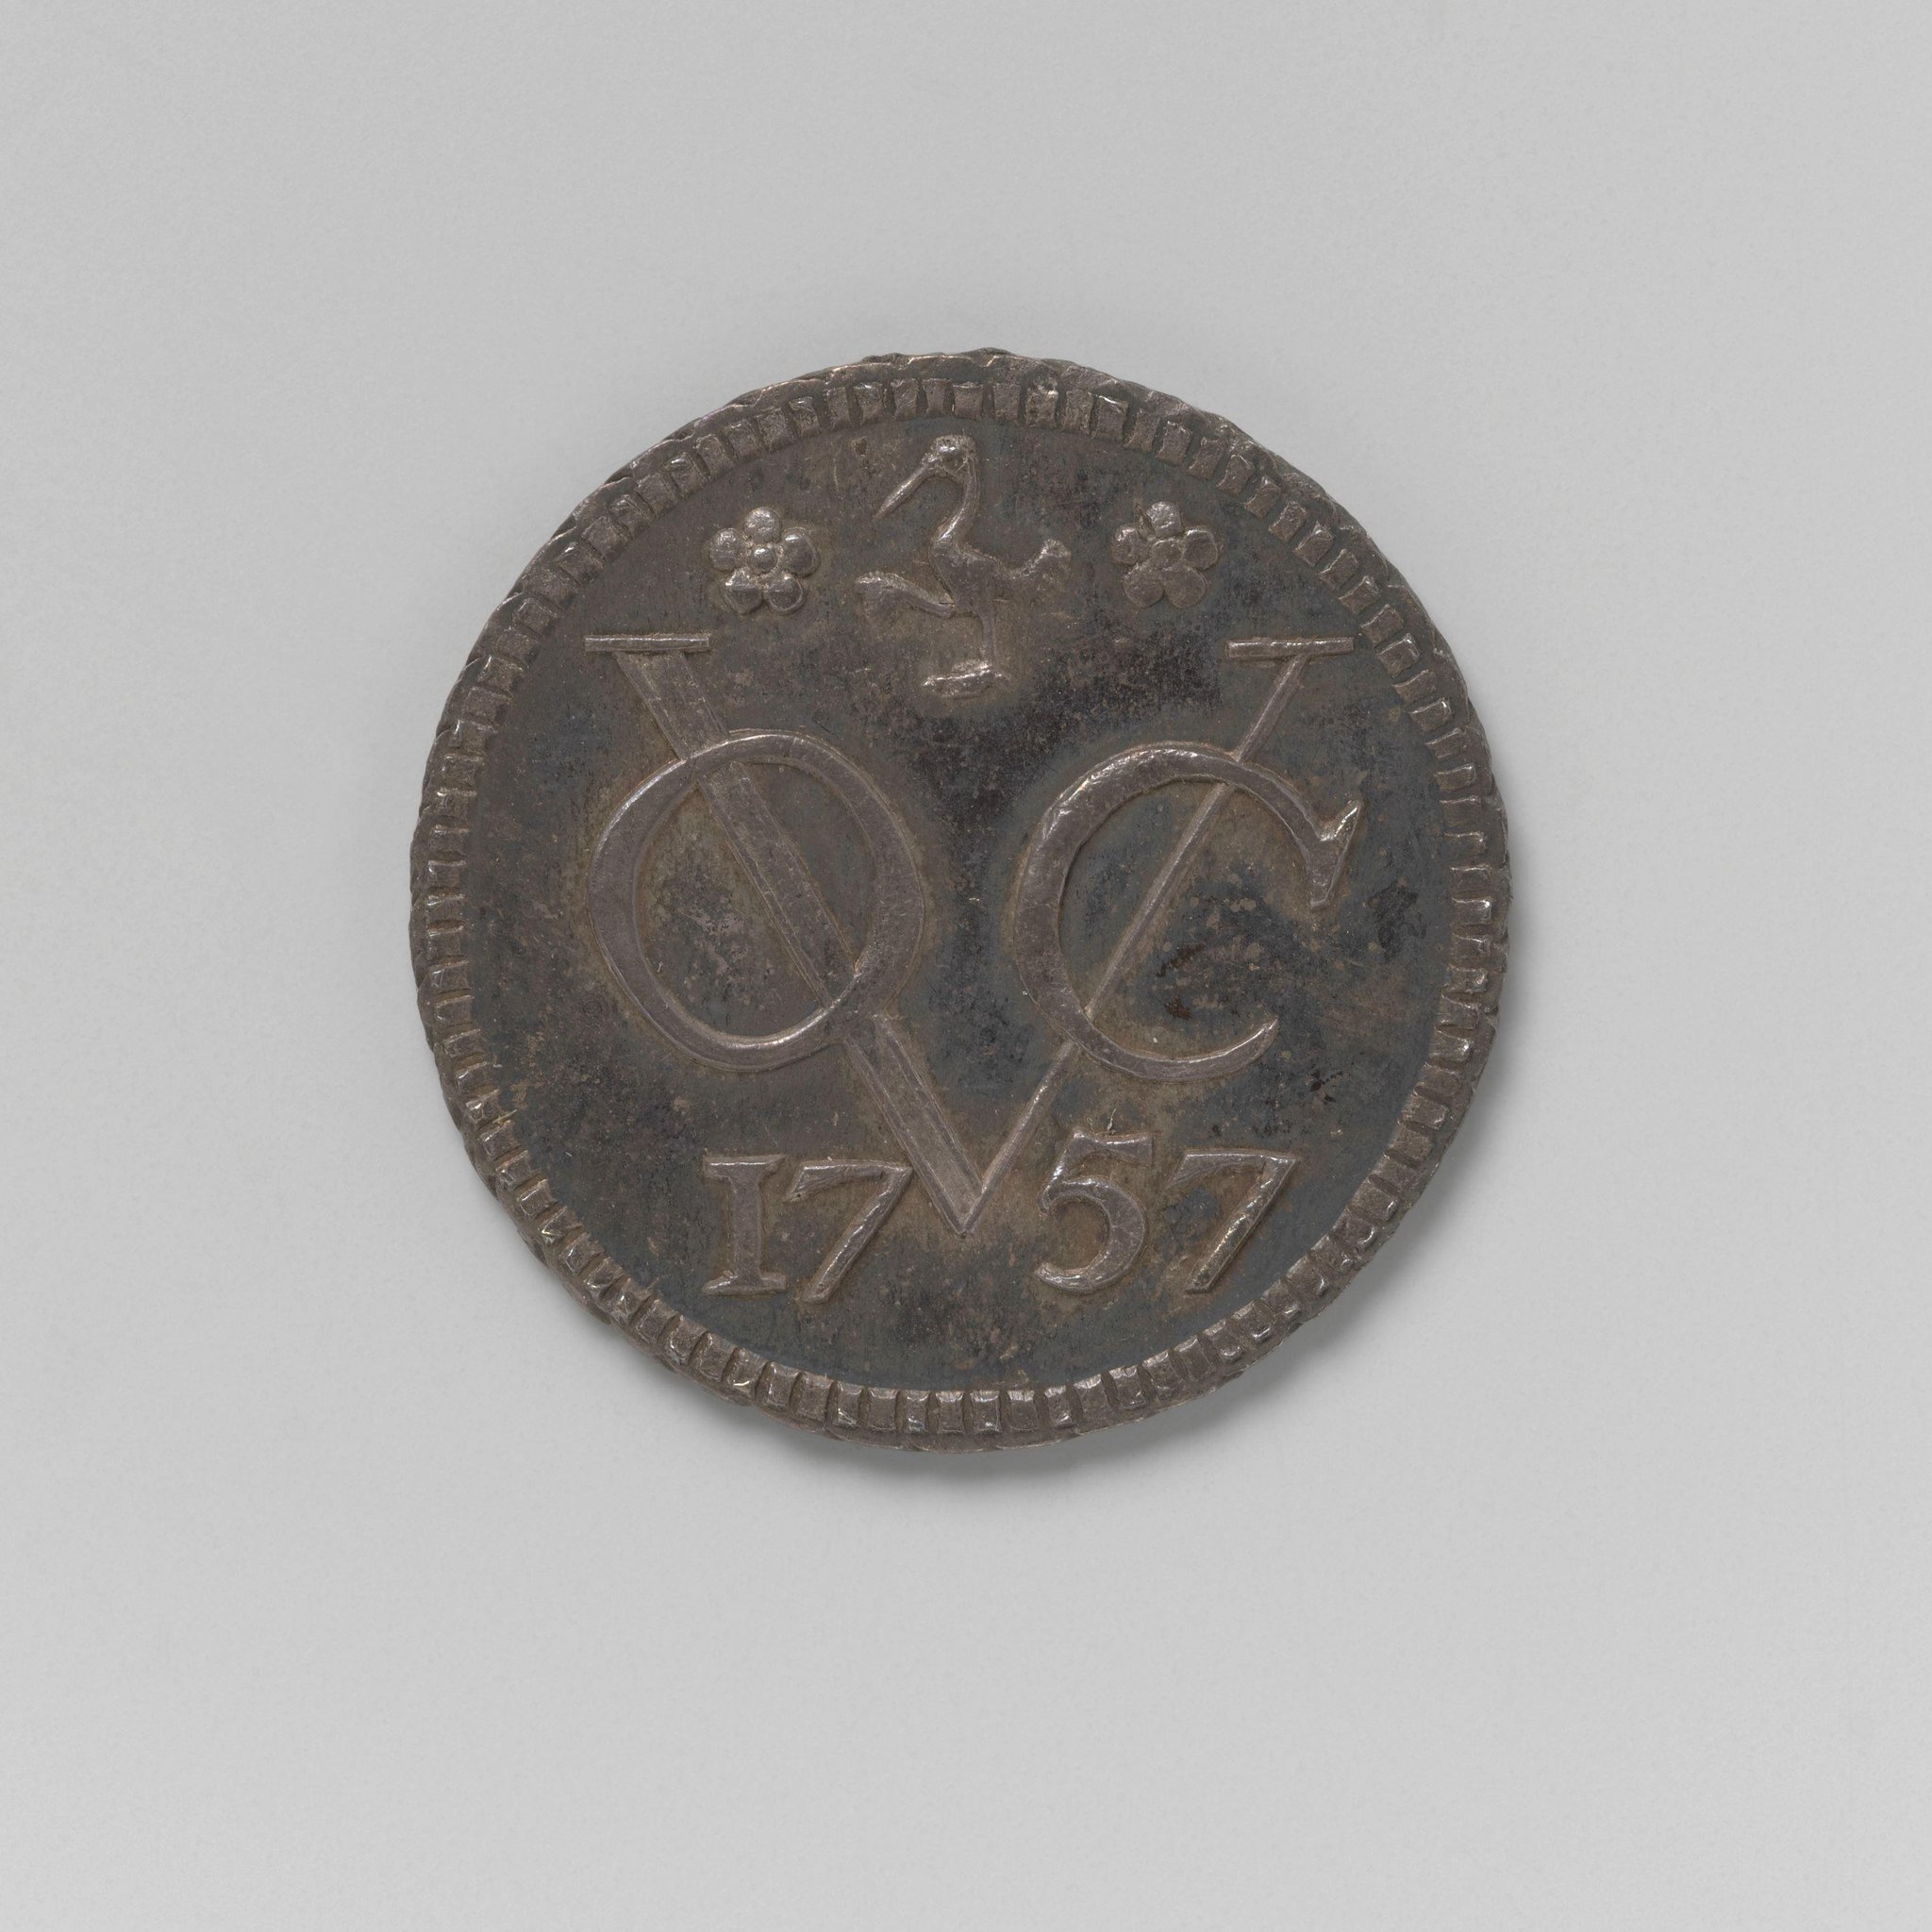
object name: coin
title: VOC, ½ duit Gelderland,1757. Afslag in zilver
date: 1757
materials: silver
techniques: striking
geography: harderwijk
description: Zilveren munt. Voorzijde: tussen wapenspreuk gekroond wapenschild van Gelderland. Keerzijde: monogram van de VOC, waarboven muntmeesterteken en waaronder jaartal. Kabelrand.